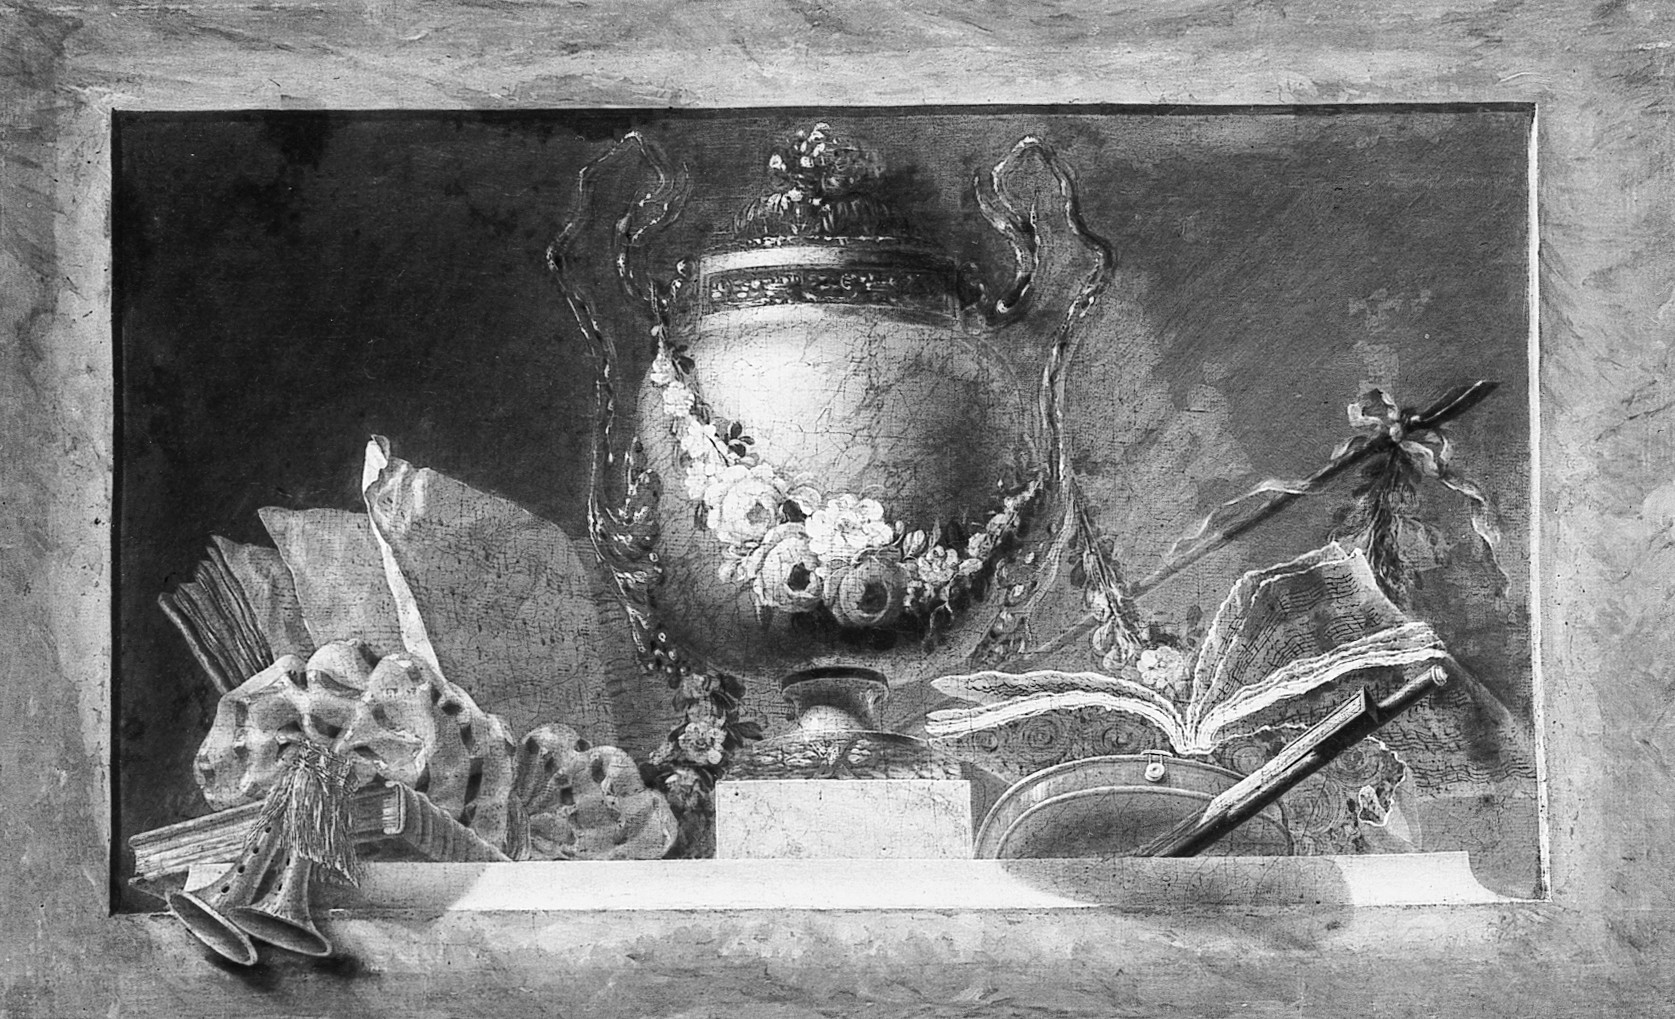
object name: overdoor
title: Still life with musical instruments (one of a pair)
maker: french painter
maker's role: artist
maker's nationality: french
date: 1701-1800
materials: canvas, oil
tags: musical instruments,flowers,still life